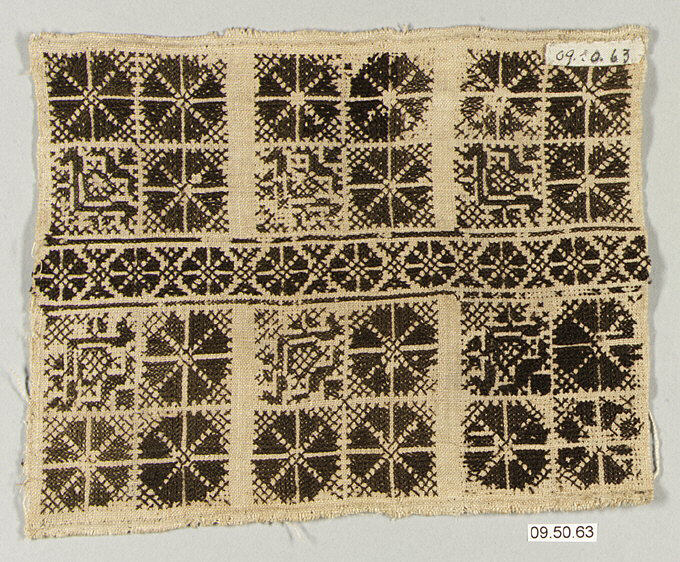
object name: fragment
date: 1801-1900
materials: linen, silk